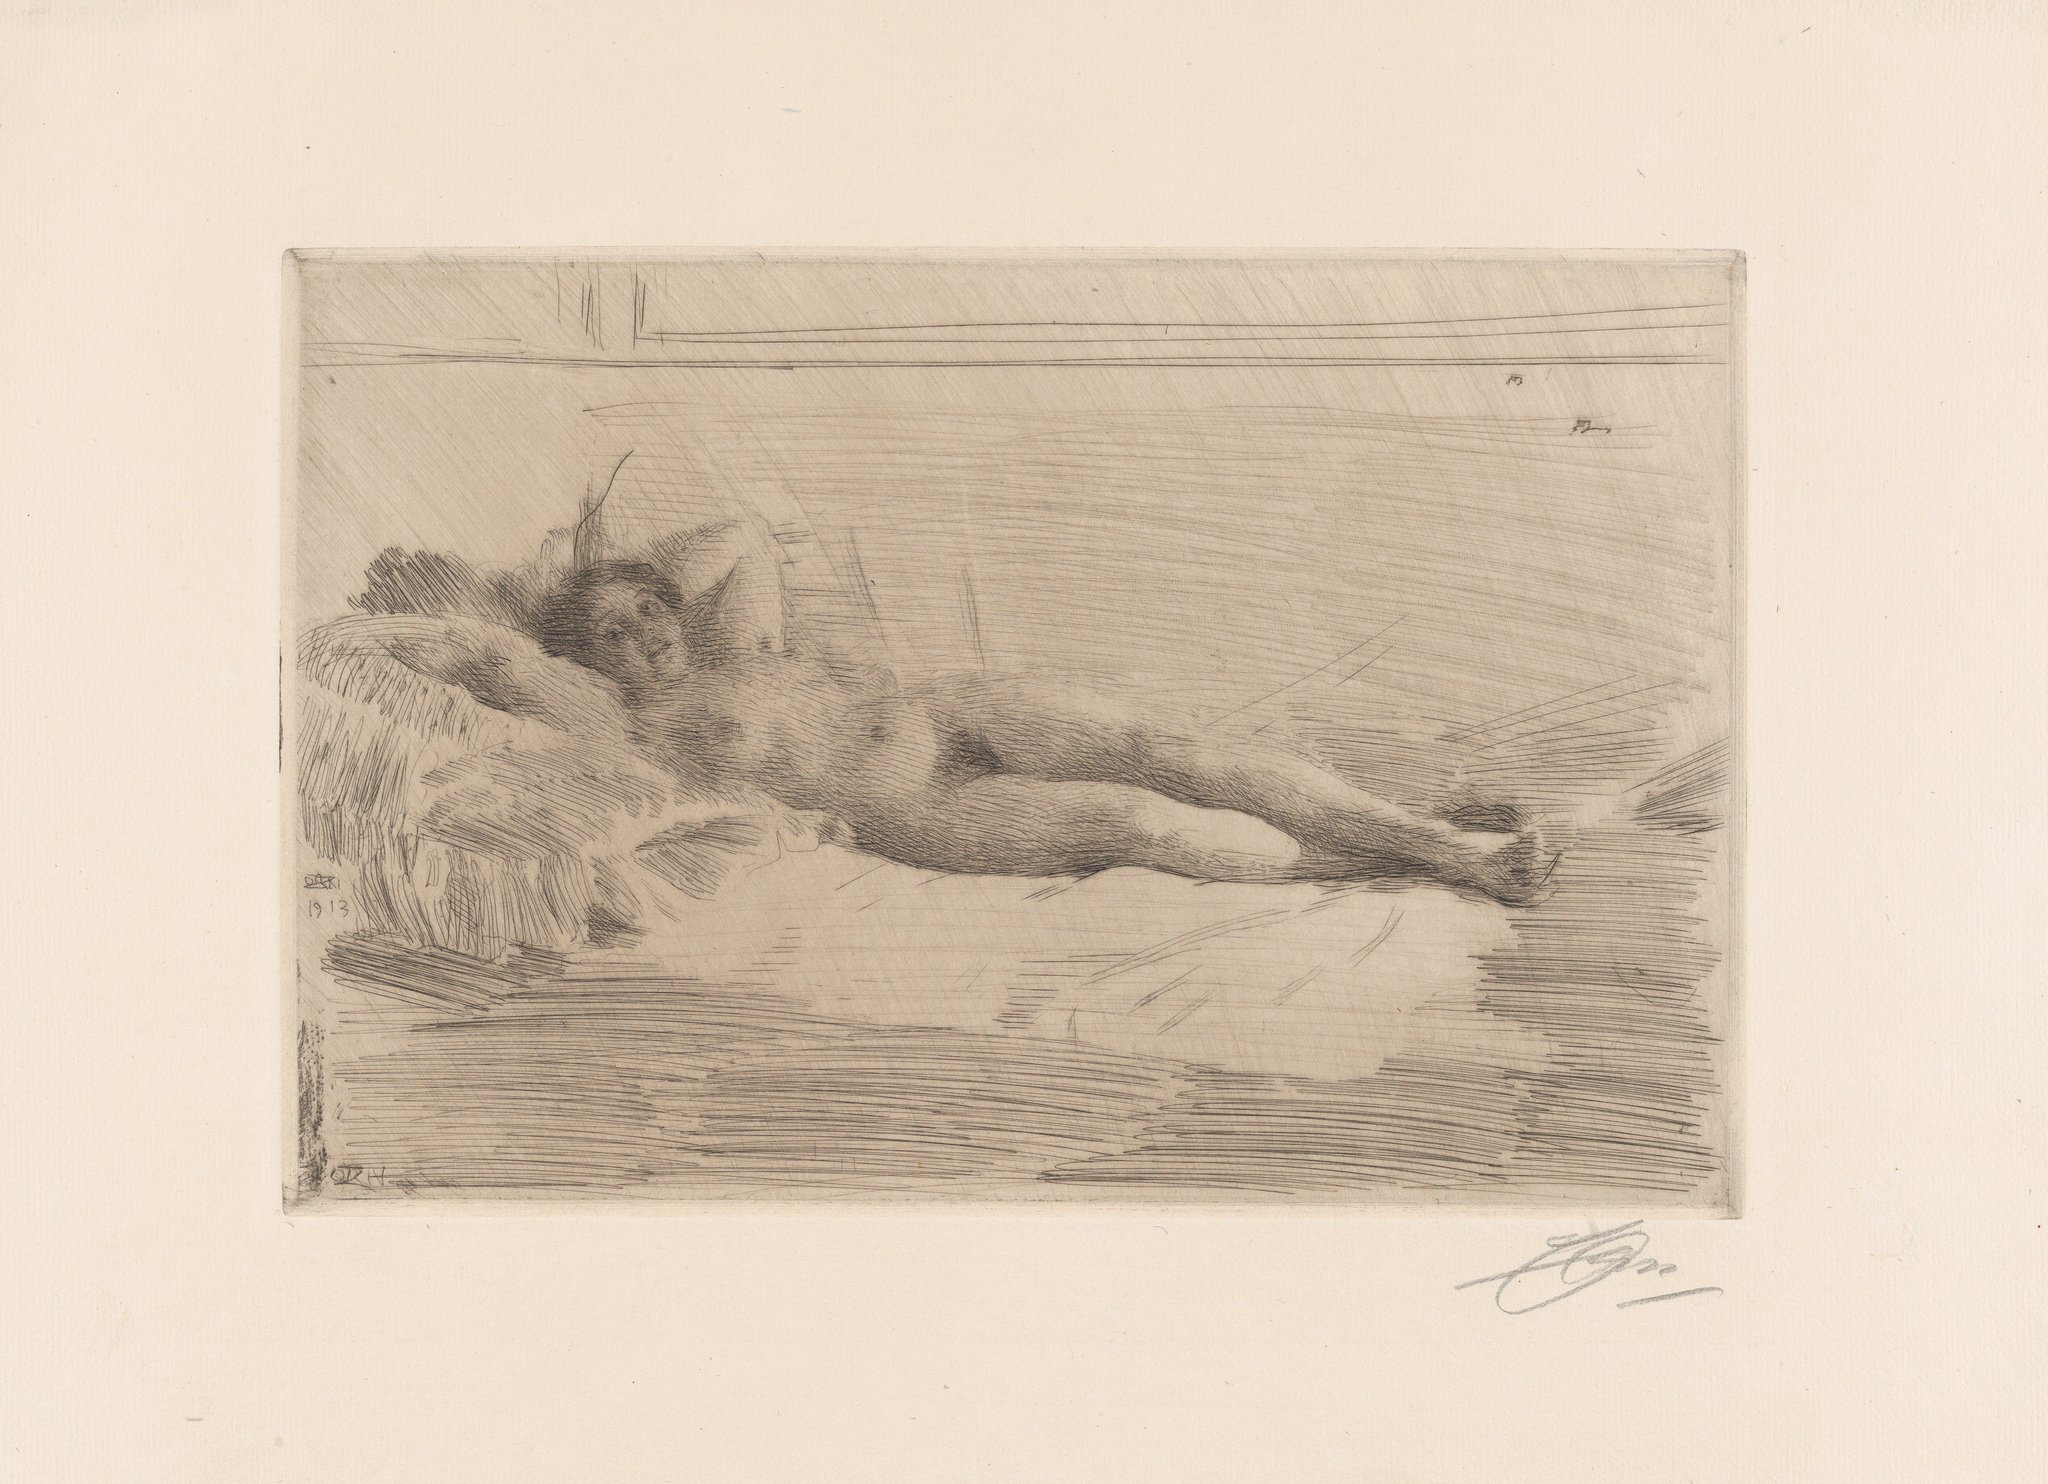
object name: print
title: Elin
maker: anders zorn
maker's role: artist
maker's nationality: swedish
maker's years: 1860-1920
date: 1913-1914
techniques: etching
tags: female nudes